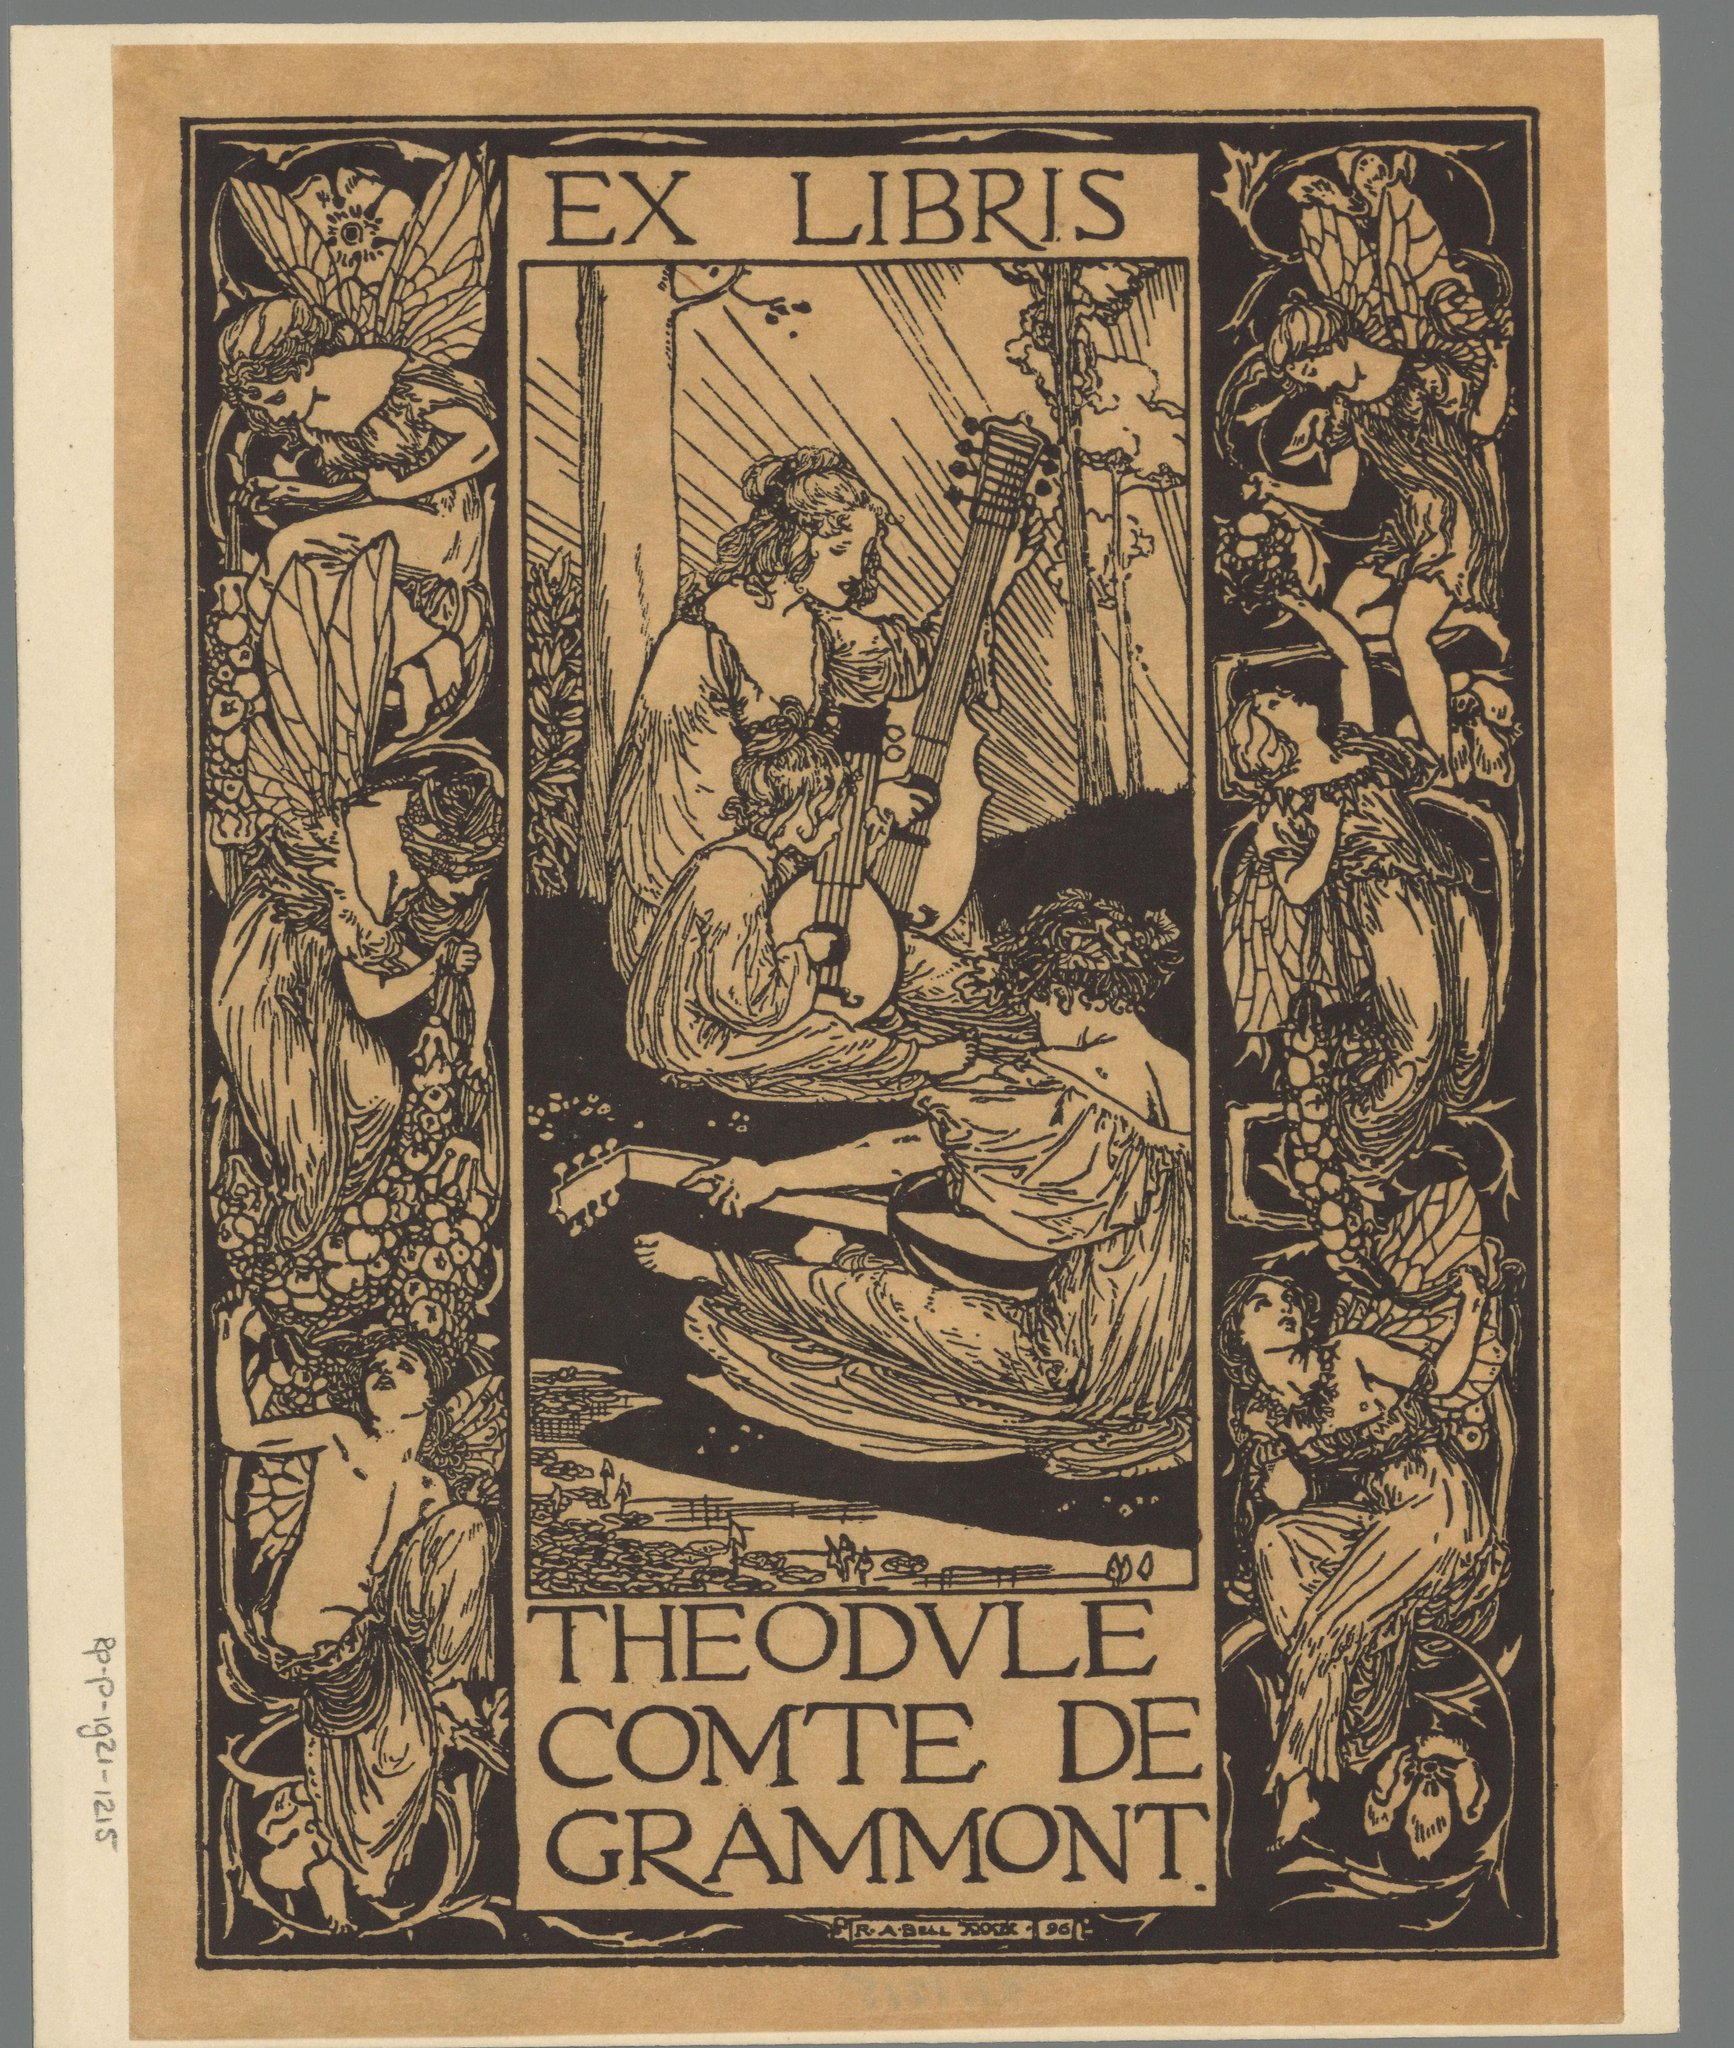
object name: bookplate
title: Ex libris van Theodule comte de Grammont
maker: robert anning bell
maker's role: painter, print maker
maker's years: 1863-1933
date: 1896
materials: paper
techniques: printing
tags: politician, fairy, lute, and special forms of lute, e.g.: theorbo - cc - out of doors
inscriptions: date